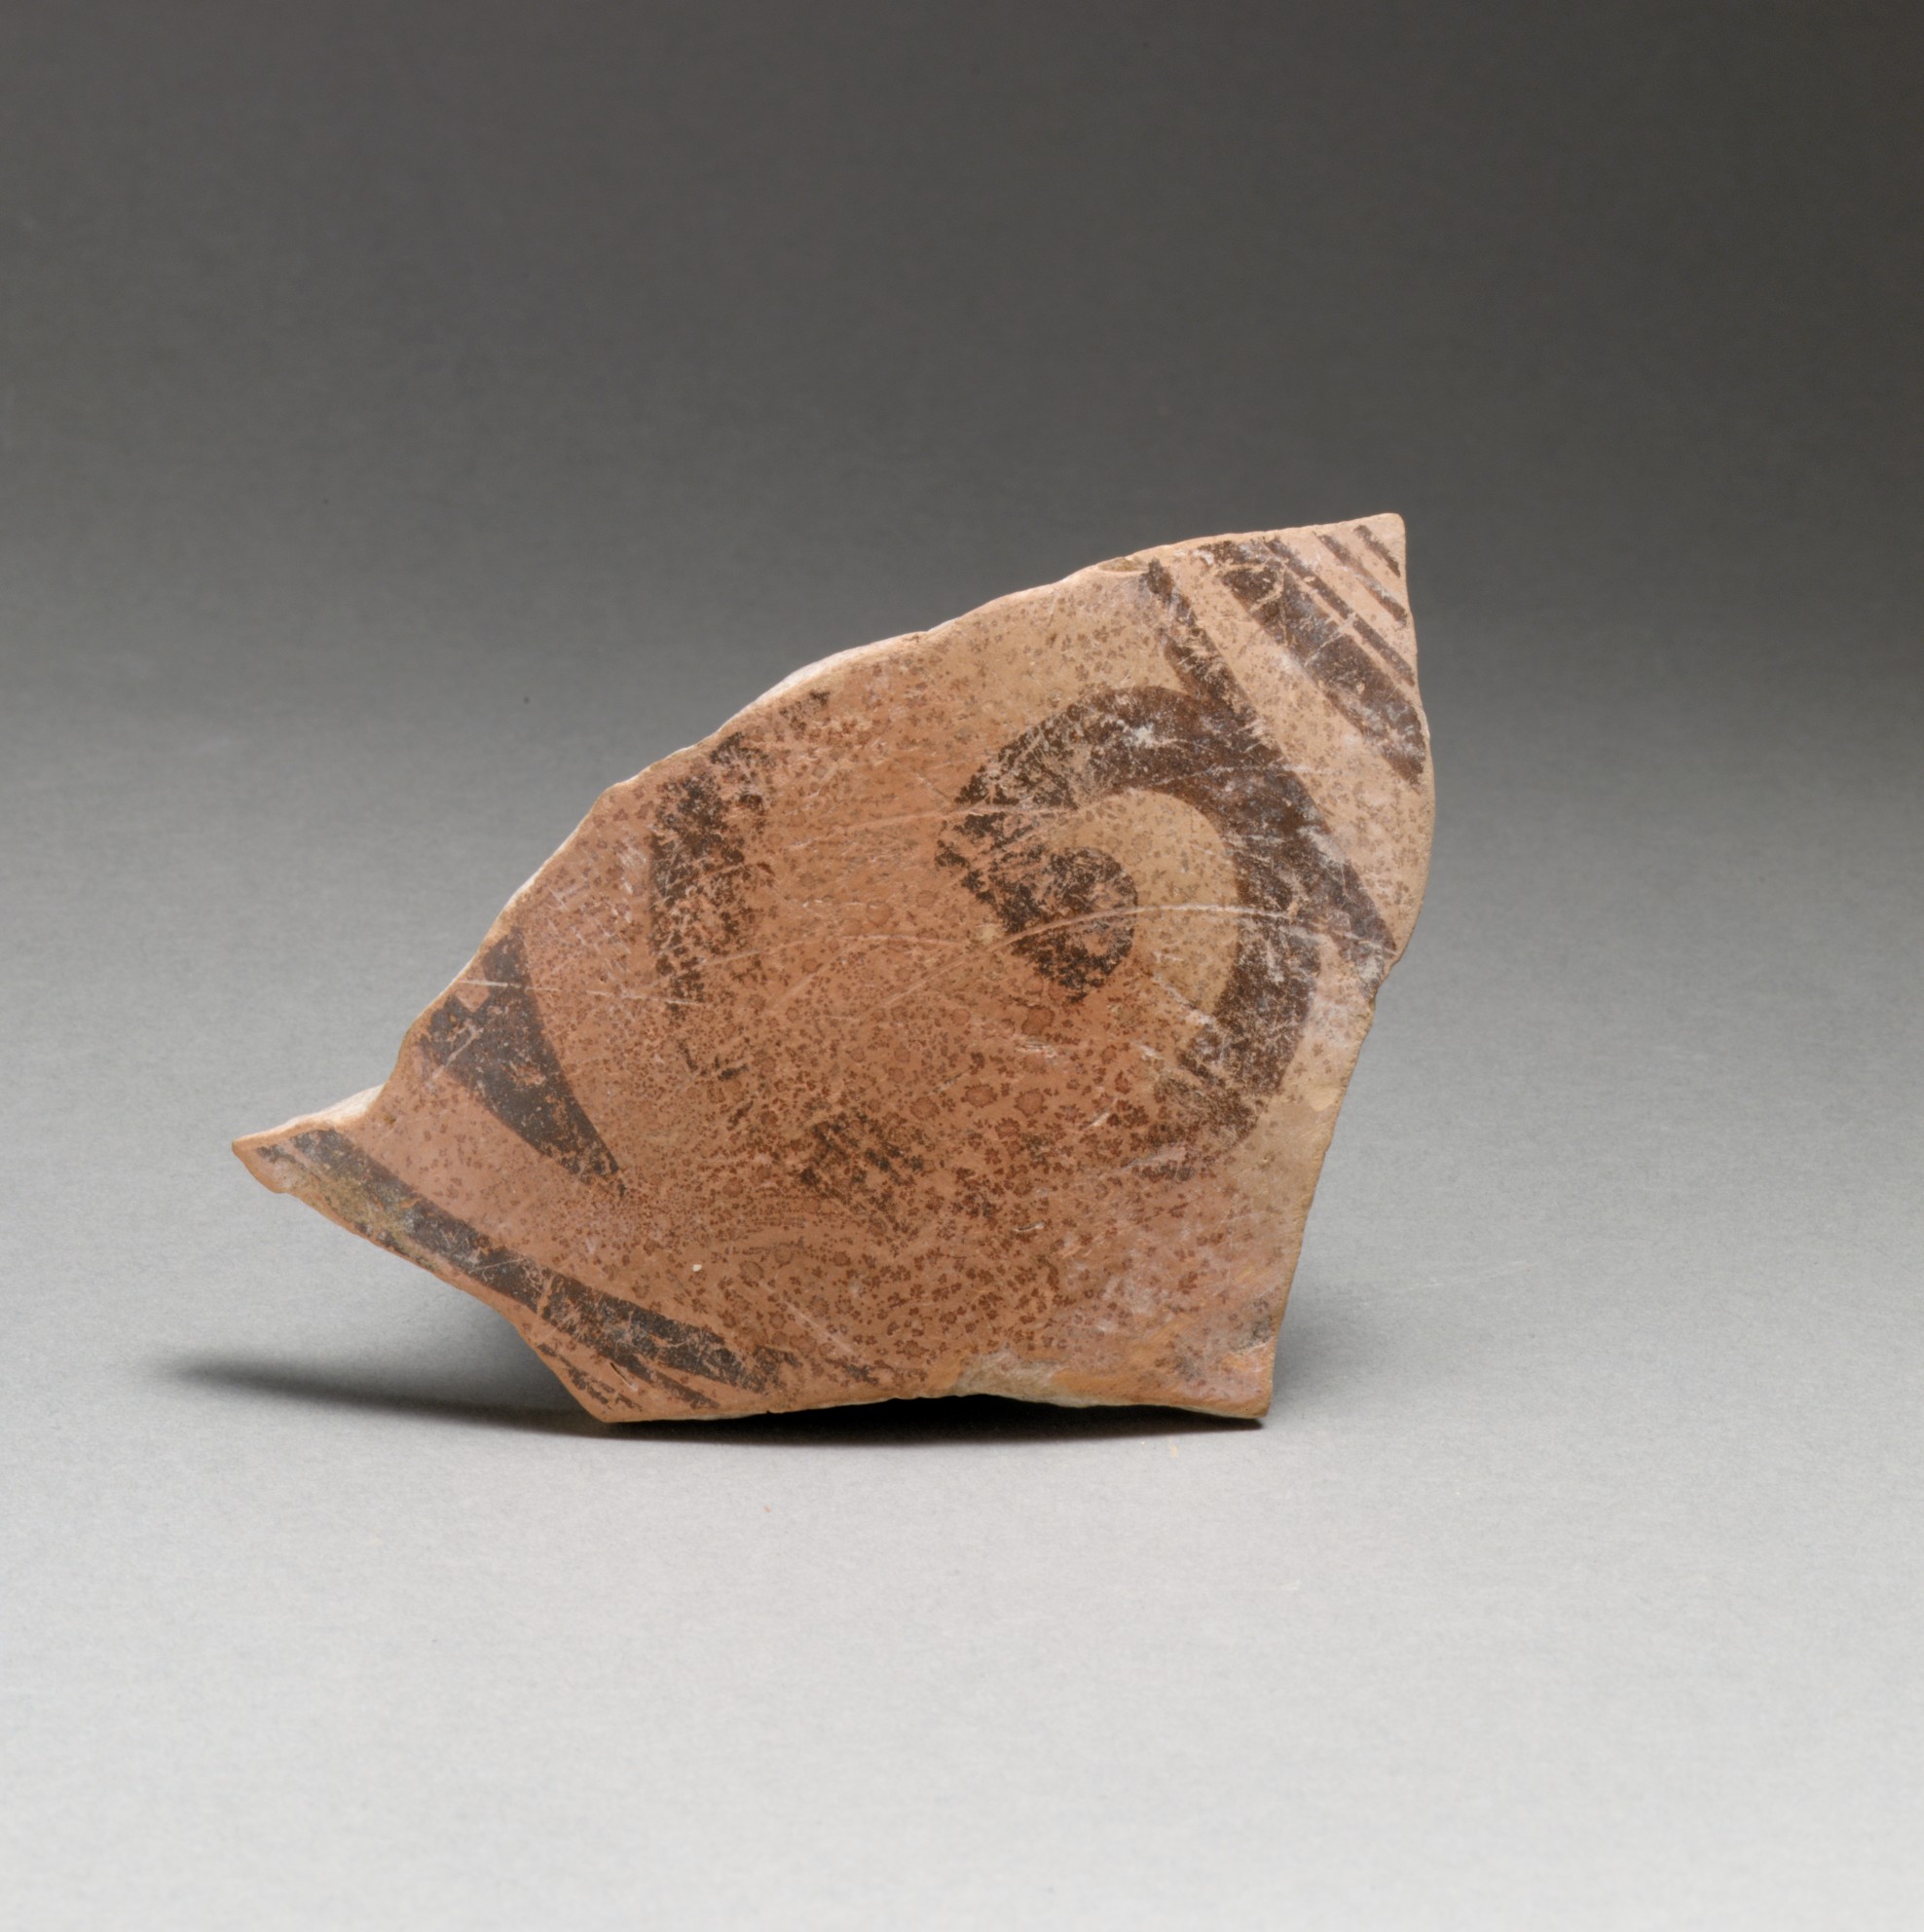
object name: vase fragment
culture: neolithic, thessaly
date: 4000-3000 BCE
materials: terracotta